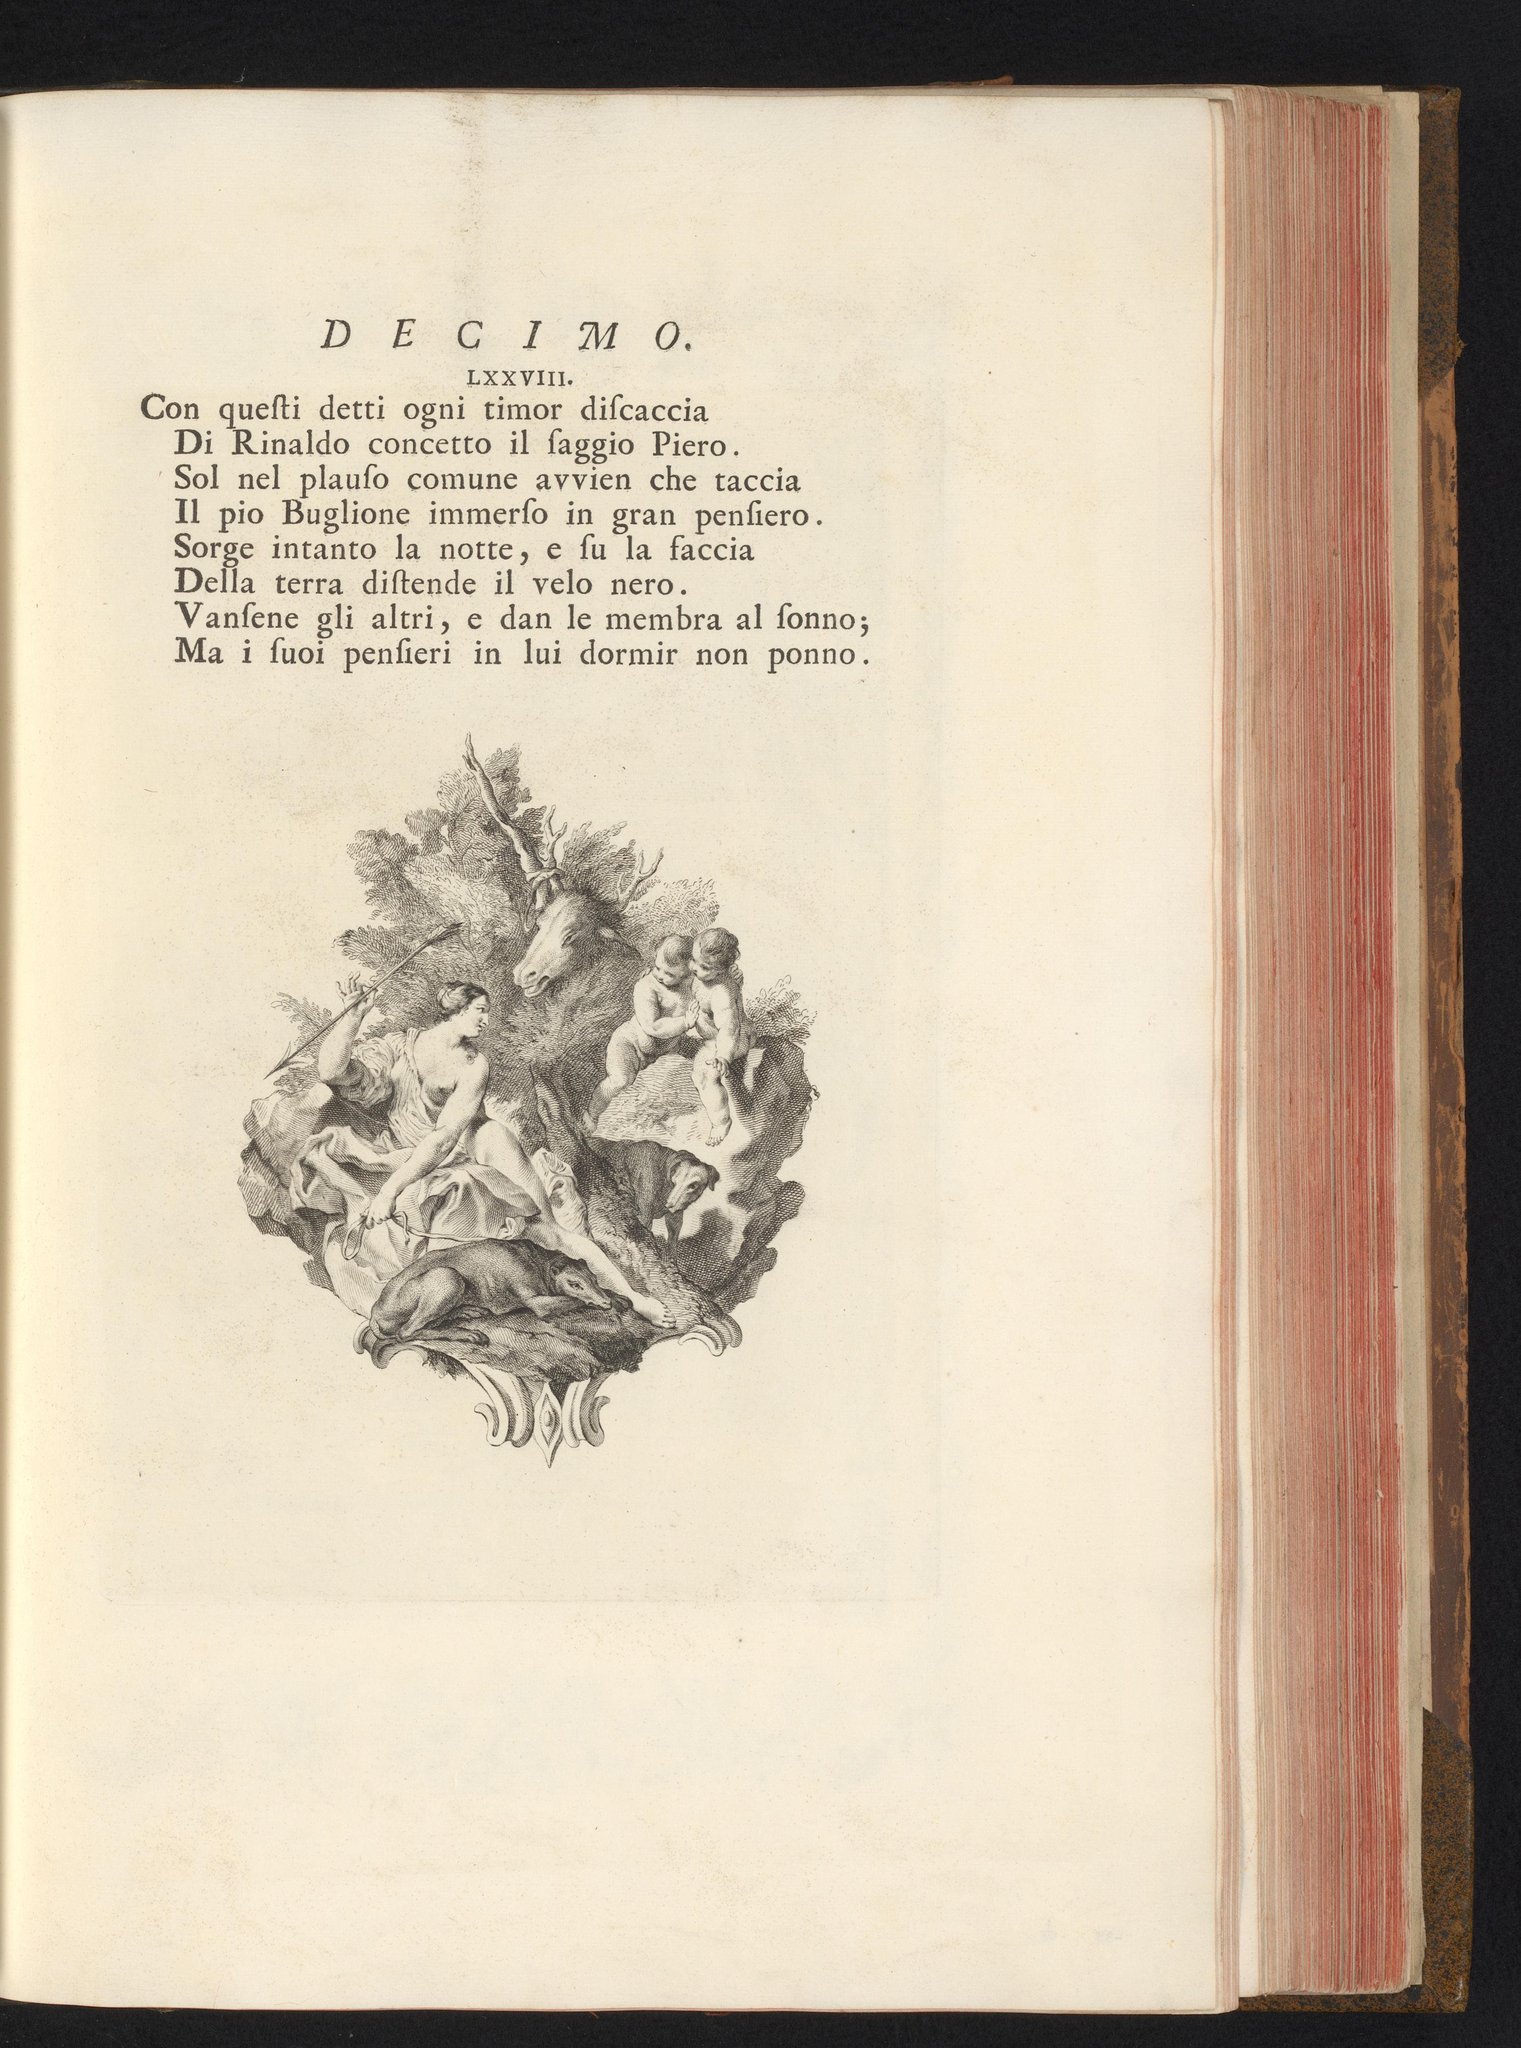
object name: print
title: Vrouw met jachthonden en pijl met twee putti en een hertenkop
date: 1745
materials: paper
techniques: etching, letterpress printing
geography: venice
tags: hunting dogs, archer's weapons: arrow, (scenes from) specific works of literature: tasso, gerusalemme liberata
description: Prent uit: Tasso, Torquato. La Gerusalemme liberata di Torquato Tasso con le figure de Giambatista Piazzetta. Venetië: Giambatista Albrizzi, 1745.